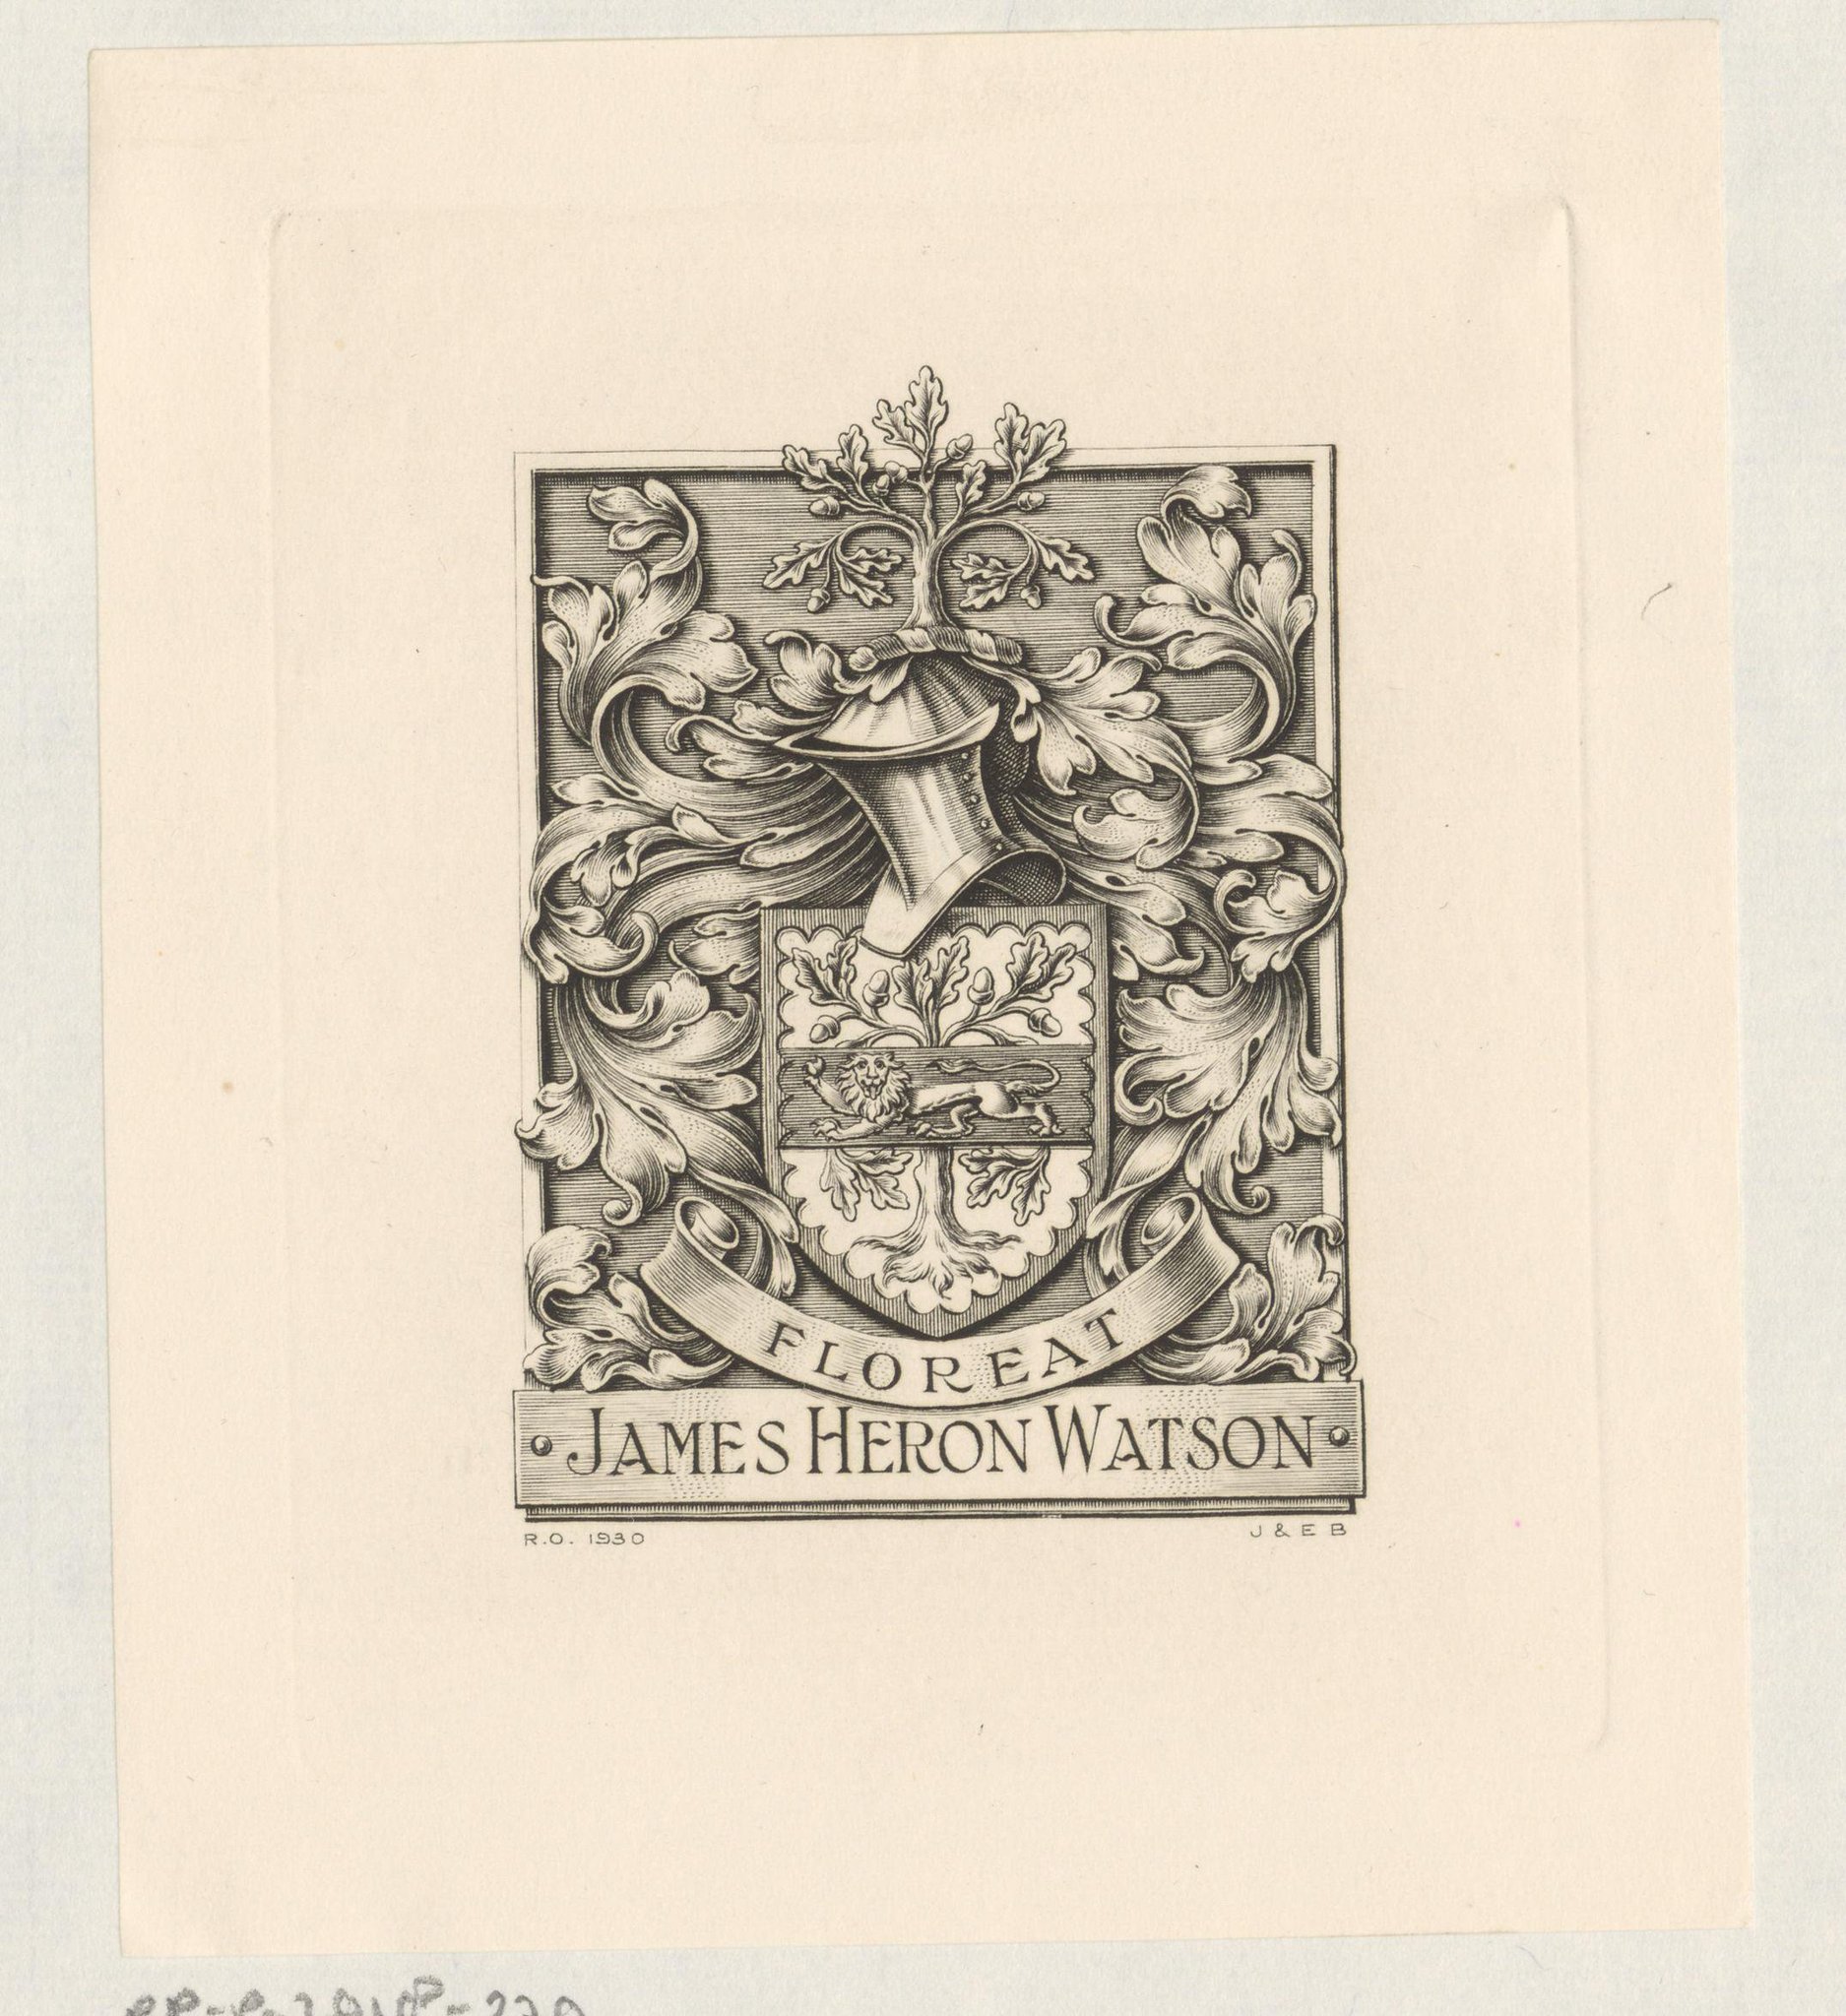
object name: bookplate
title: Vertue vaunceta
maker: Anonymous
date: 1930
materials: paper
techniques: engraving, etching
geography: england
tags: trees: oak, beasts of prey, predatory animals: lion, armorial bearing, heraldry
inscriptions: date